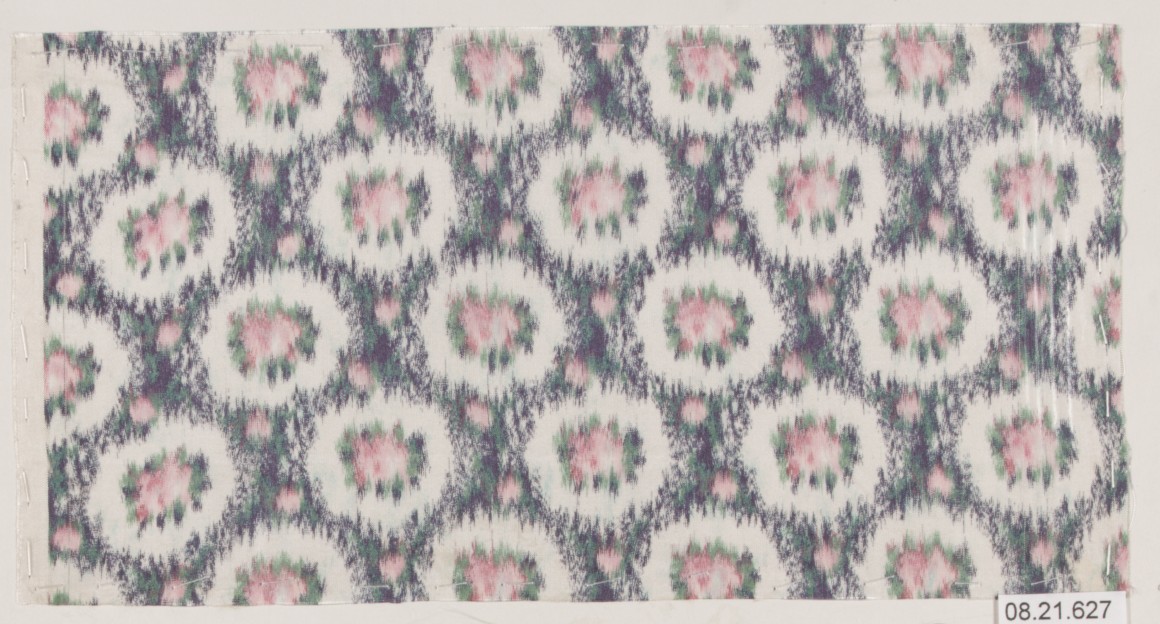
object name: textile sample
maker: Anonymous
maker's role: designer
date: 1900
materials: silk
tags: flowers